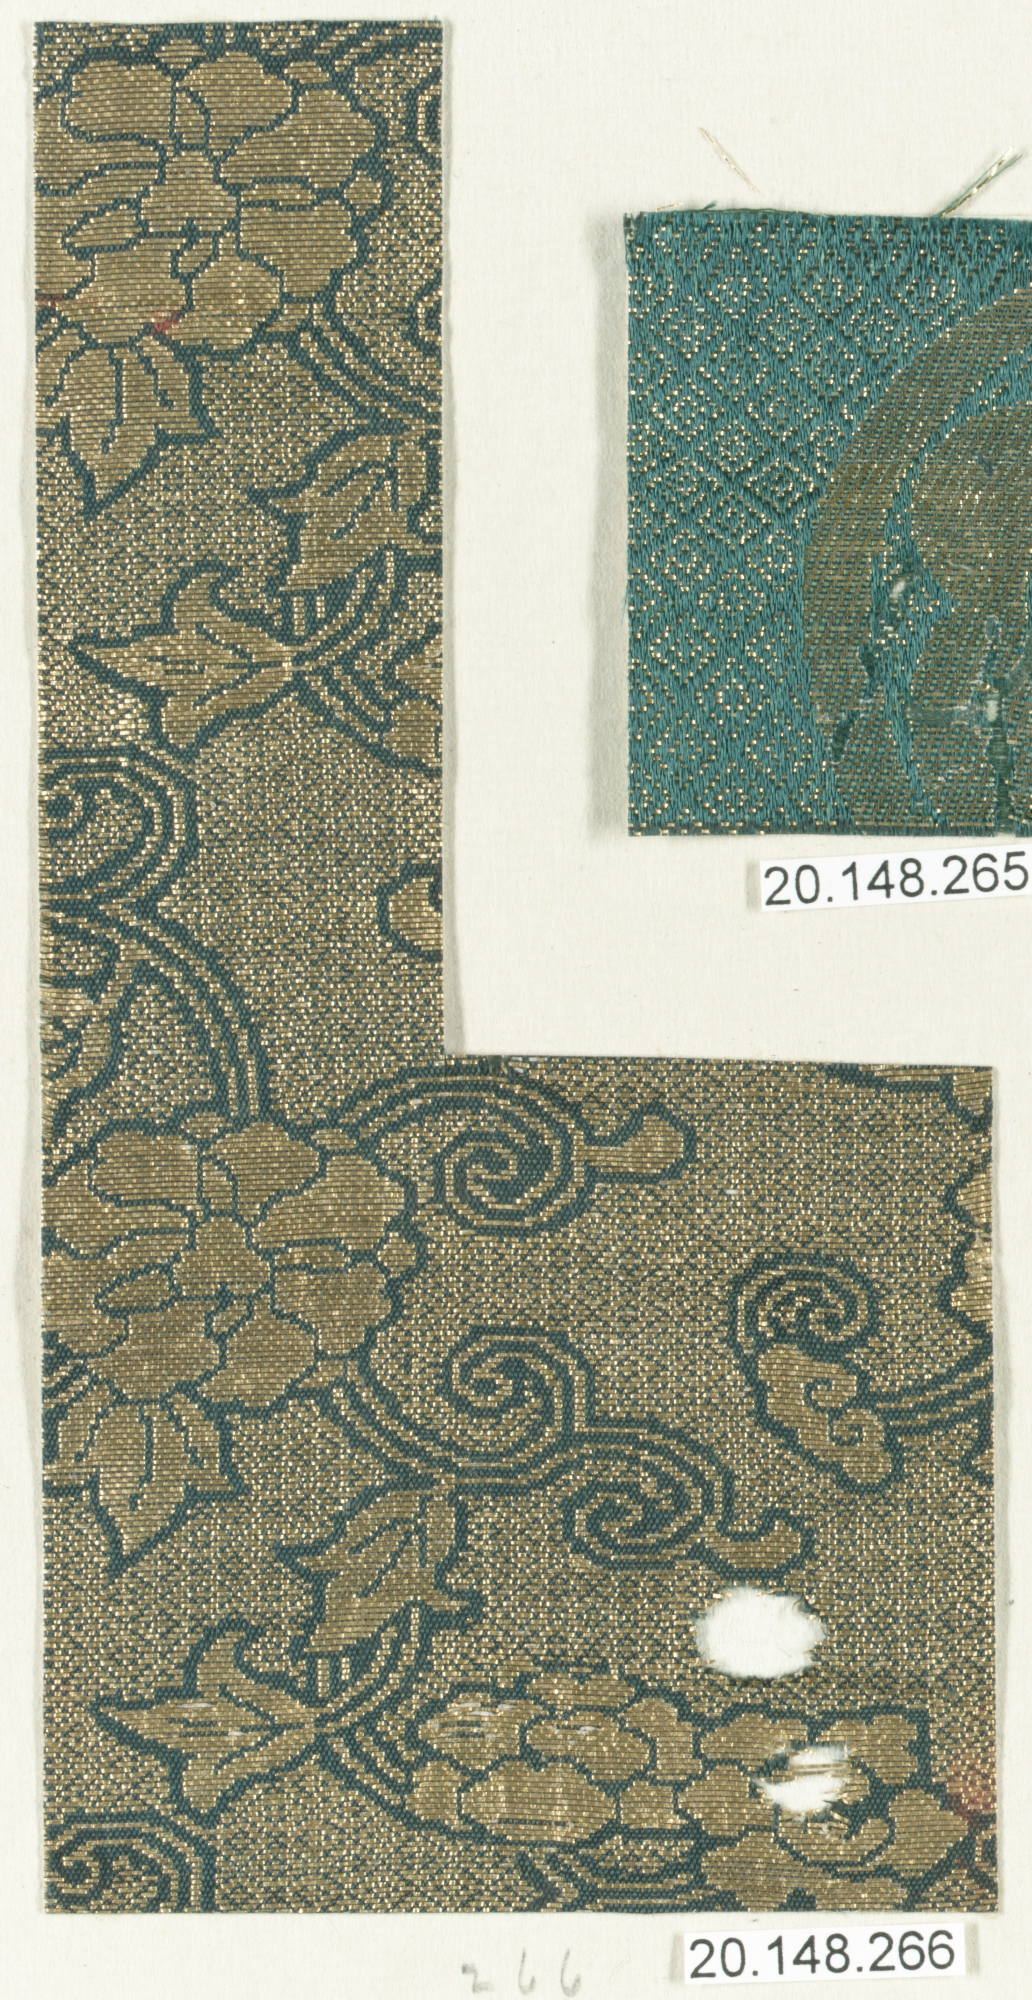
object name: piece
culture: japanese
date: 1701-1800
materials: silk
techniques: compound weave